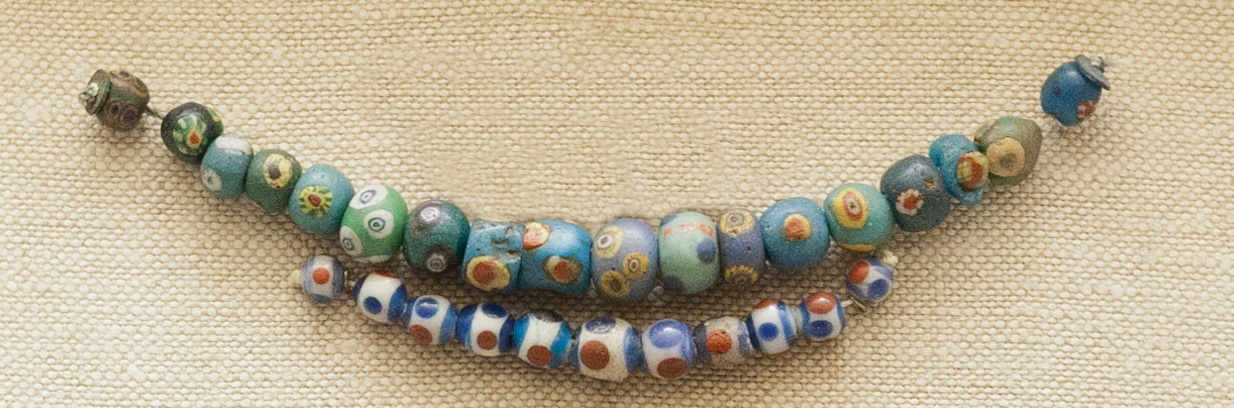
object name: necklace, bead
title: String of 11 Eyed Beads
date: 1300-1200 BCE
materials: glass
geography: egypt